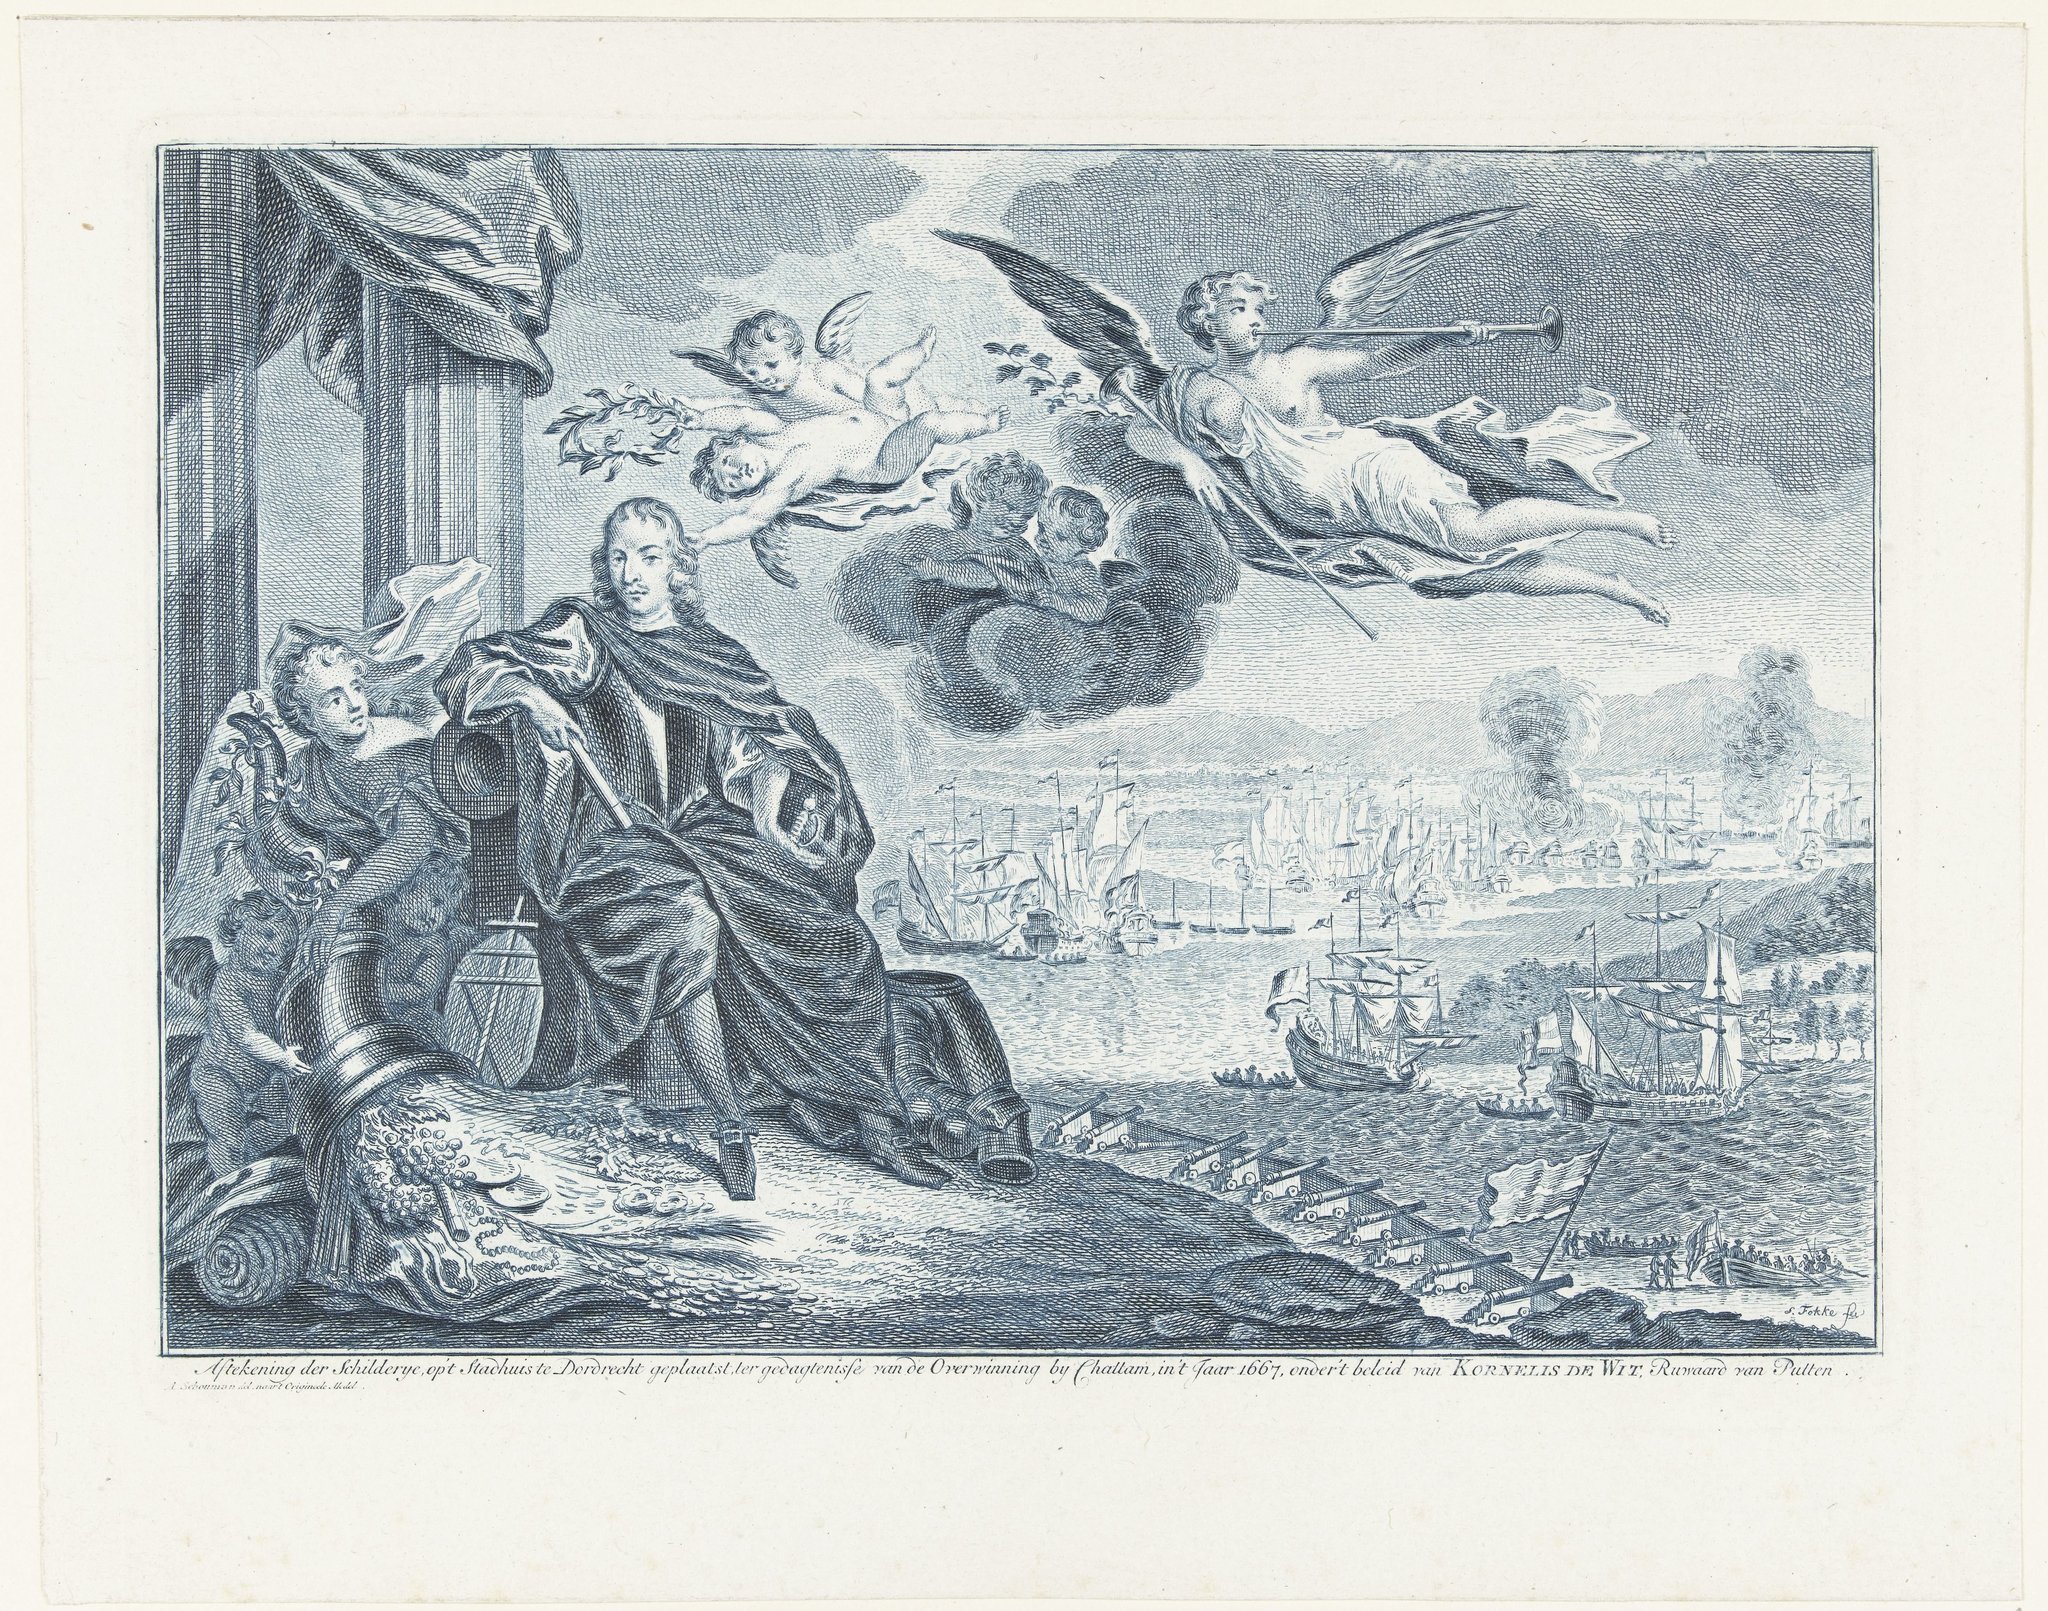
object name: history print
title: Aftekening der Schilderye, op 't Stadhuis te Dordrecht geplaatst, ter gedagtenisse van de Overwinning by Chattam, in 't Jaar 1667, onder 't beleid van Kornelis de Wit, Ruwaard van Putten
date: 1747-1759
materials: paper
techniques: etching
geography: northern netherlands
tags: dordrecht, the hague, cornelis de witt, battle (+ naval force), symbolic triumphs of individual persons, fame; 'fama', 'fama buona', 'fama chiara' (ripa), raid on the medway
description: Het schilderij met de verheerlijking van Cornelis de Witt, met op de achtergrond de Tocht naar Chatham (juni 1667). Links een hoorn des overvloeds met symbolen van de welvaart en rijkdom van het land. In de lucht Faam met bazuinen en putti met een lauwerkrans. De Witt is voorgesteld in wapenrusting en met commandostaf als teken van zijn functie als gevolmachtigde van de Staten-Generaal bij de vloot.